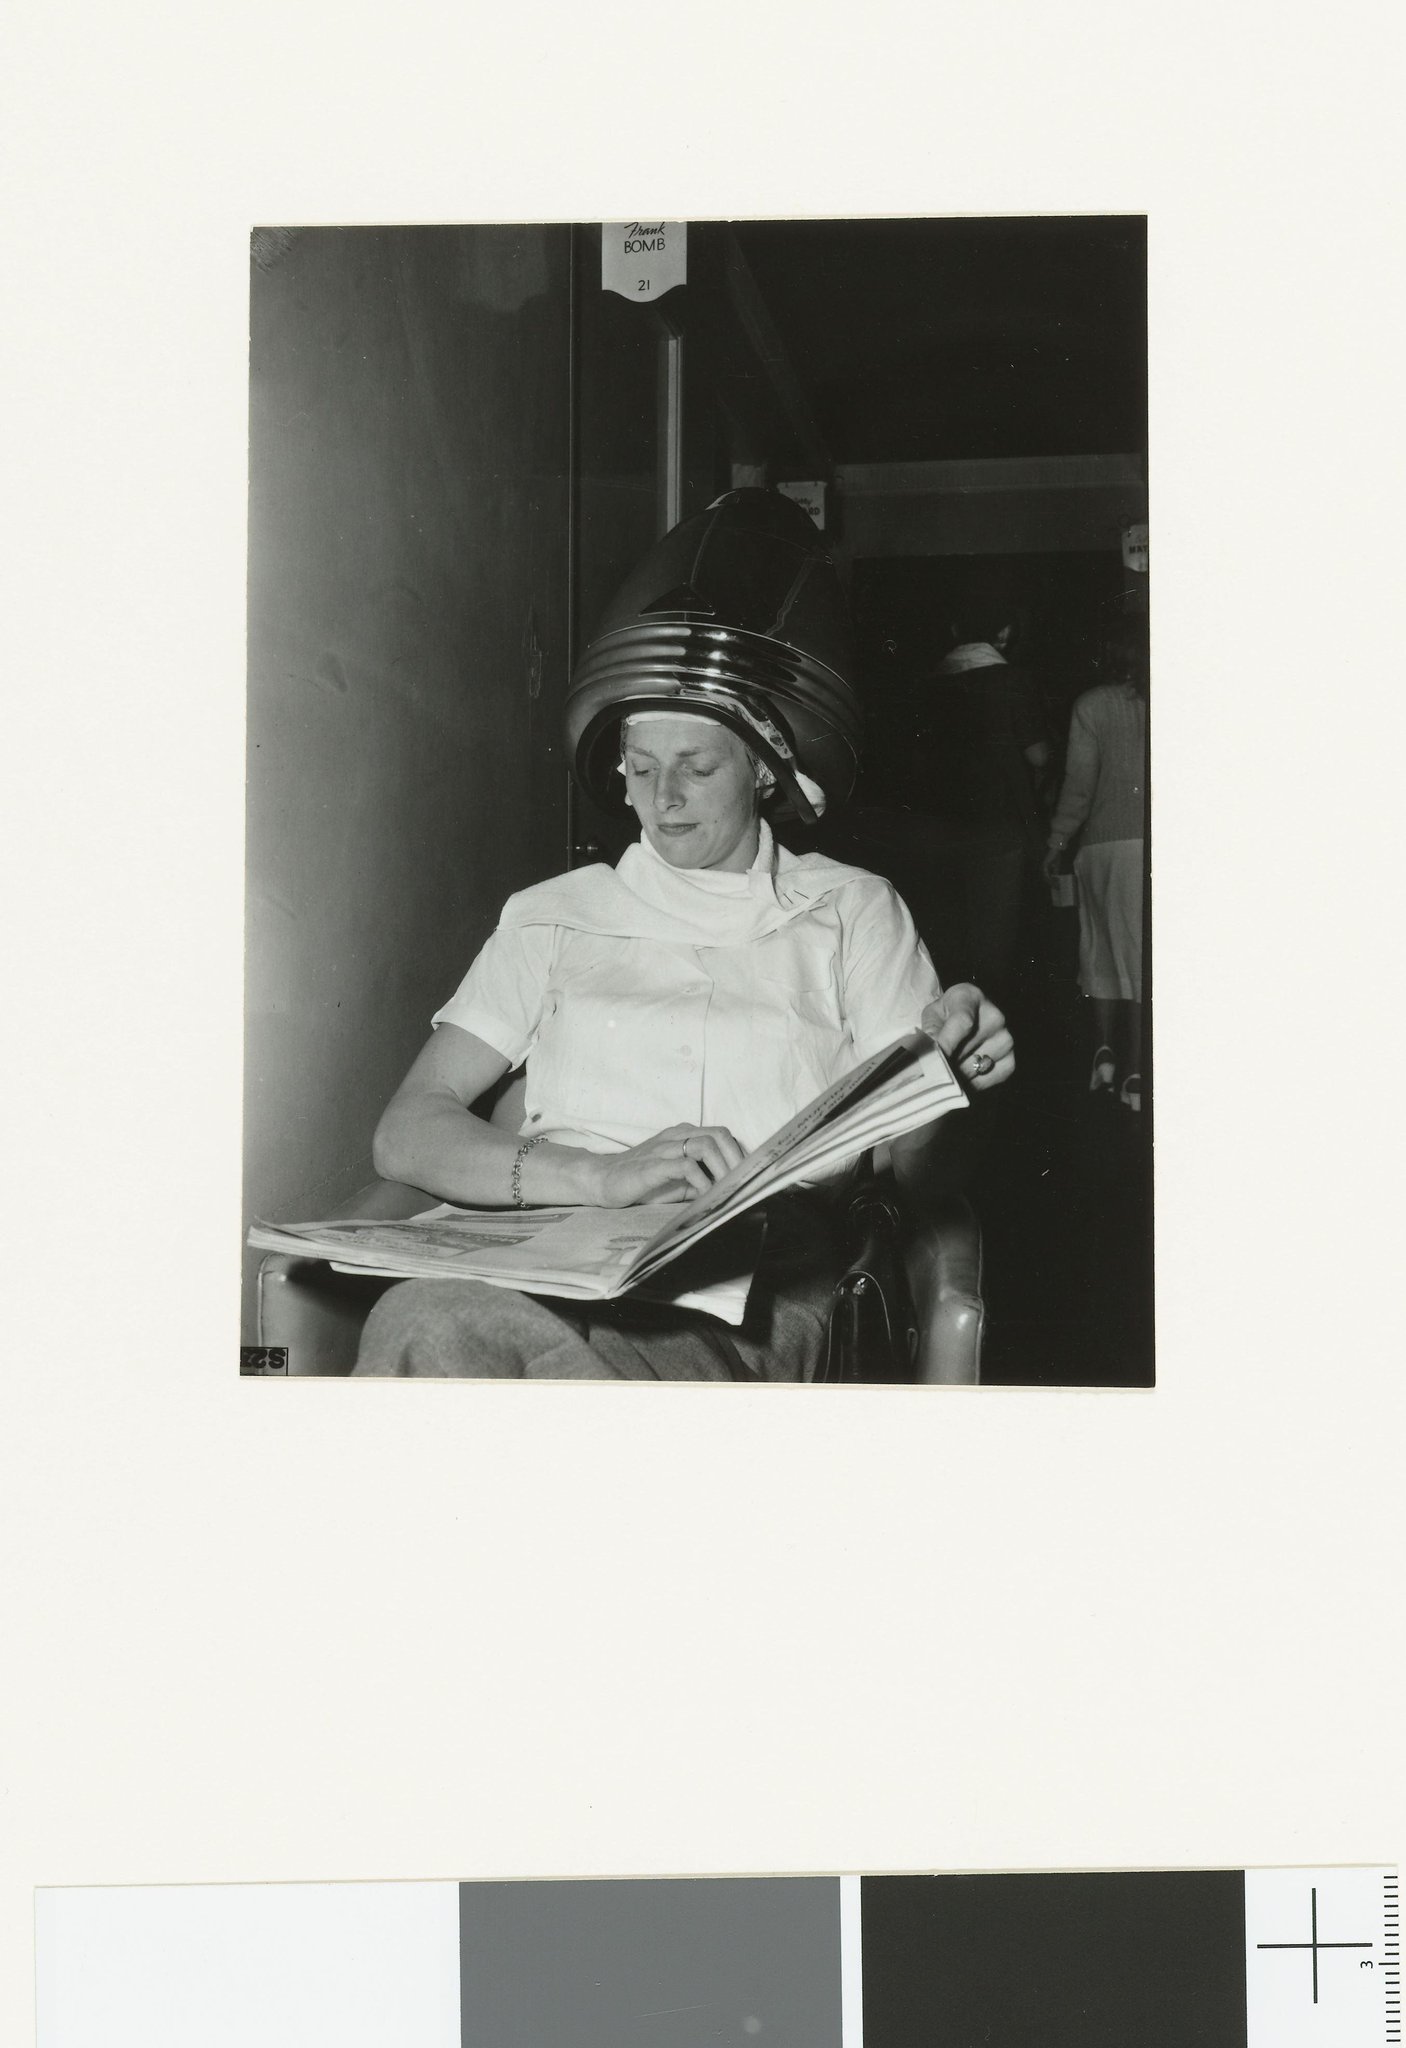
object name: documentary photograph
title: Fanny in Amerika. Ster der Olympische Spelen in New York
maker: Anonymous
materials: photographic support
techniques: photography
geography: hollywood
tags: publisher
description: Fanny Blankers-Koen ondergaat een schoonheidsbehandeling in 'House of Westmore', een schoonheidssalon in Hollywood. Fanny leest een tijdschrift tijdens het drogen van haar haren onder de droogkap. De serie 'Fanny in Amerika' bevat zes foto's.